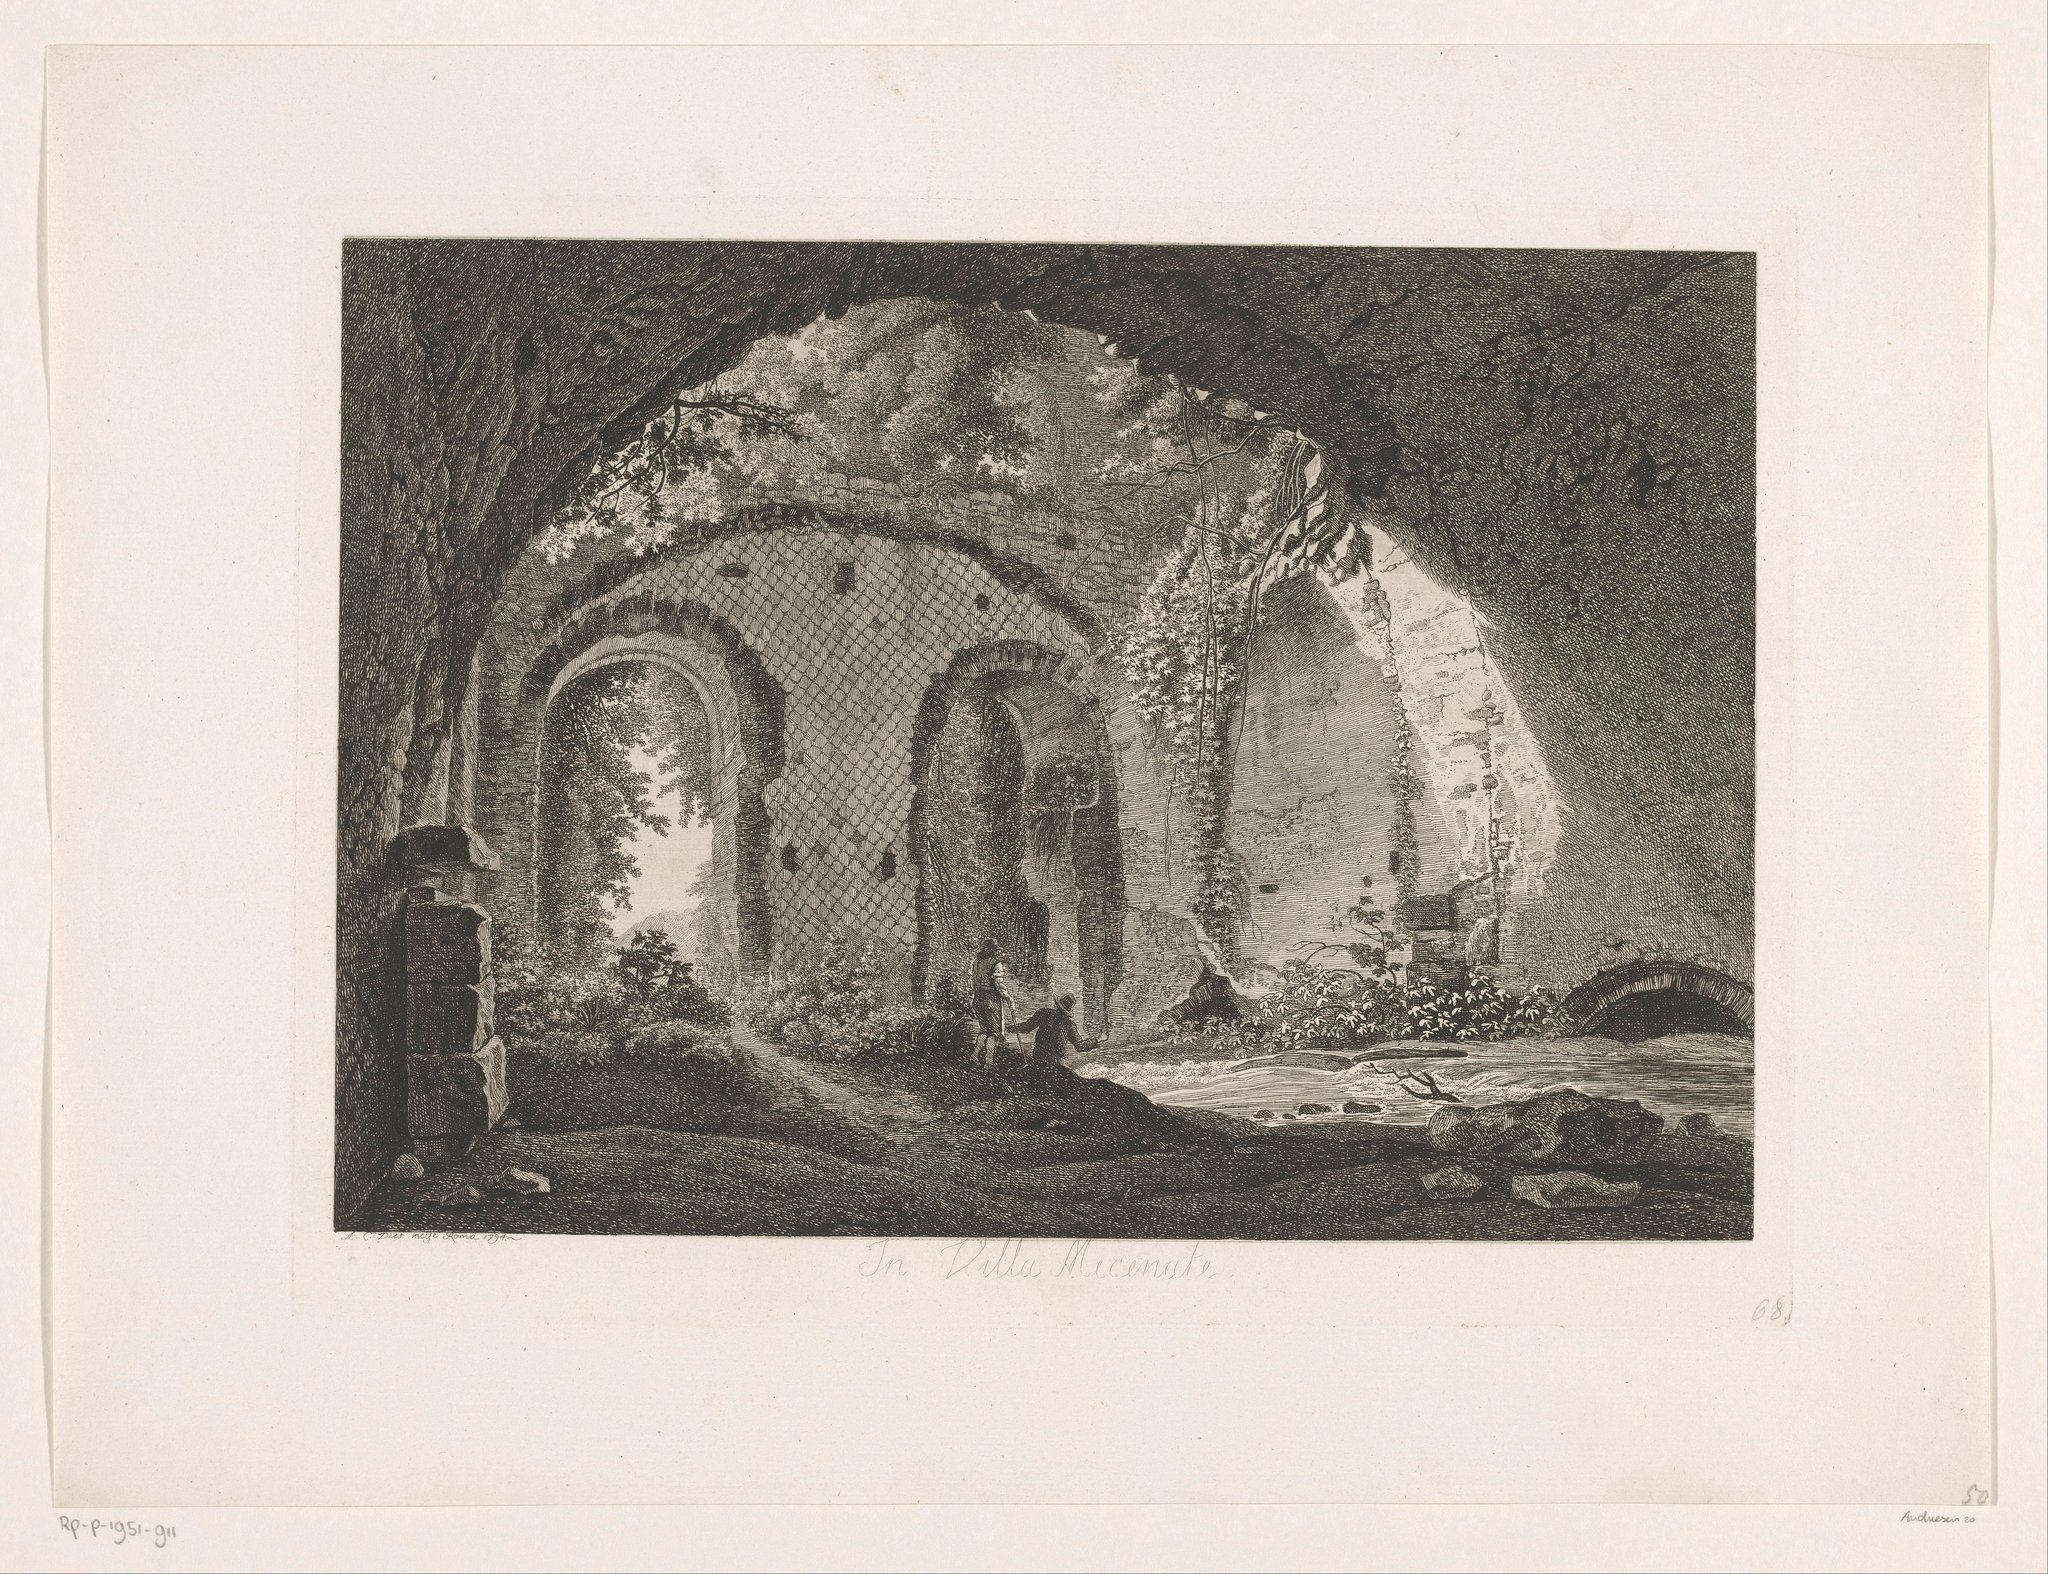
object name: print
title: Malerisch radirte Prospekte aus Italien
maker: albert christoph dies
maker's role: painter, print maker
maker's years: 1755-1822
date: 1794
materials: paper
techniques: etching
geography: rome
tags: interior ~ representation of a building, brook (+ landscape with figures, staffage), ruin of a dwelling, house, castle, etc., temple of hercules victor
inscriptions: collector's mark: Lugt 2228